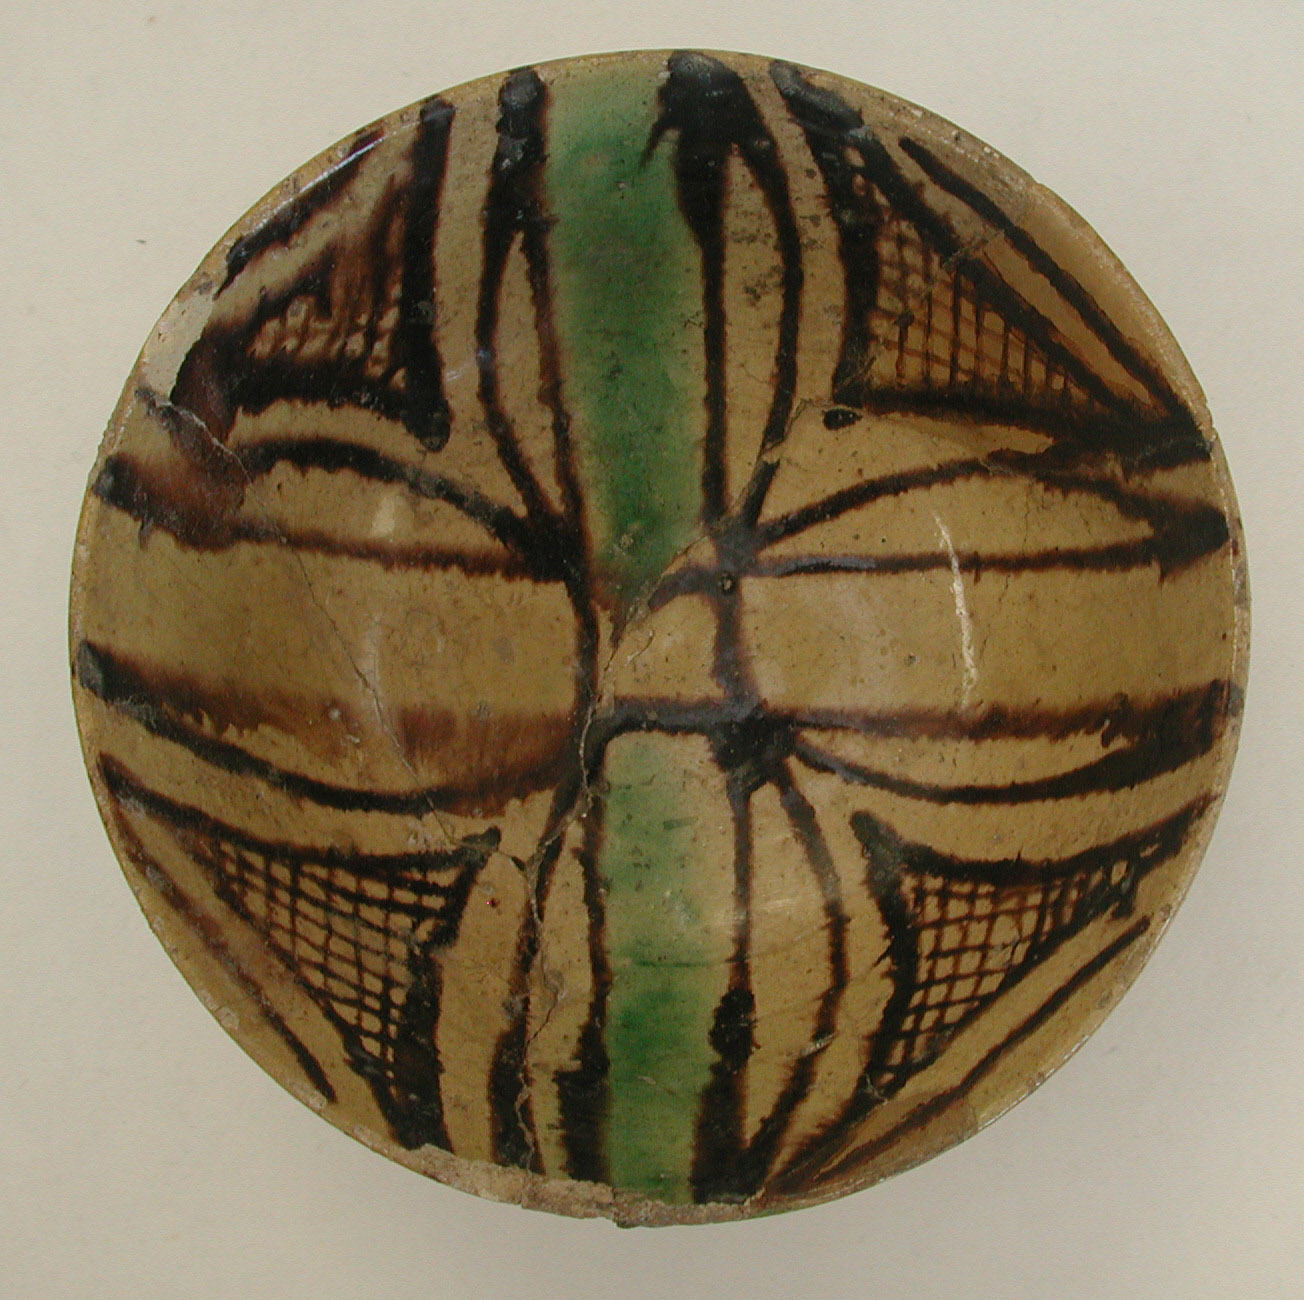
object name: dish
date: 767-833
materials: earthenware, glaze, pigment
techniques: polychrome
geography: iran